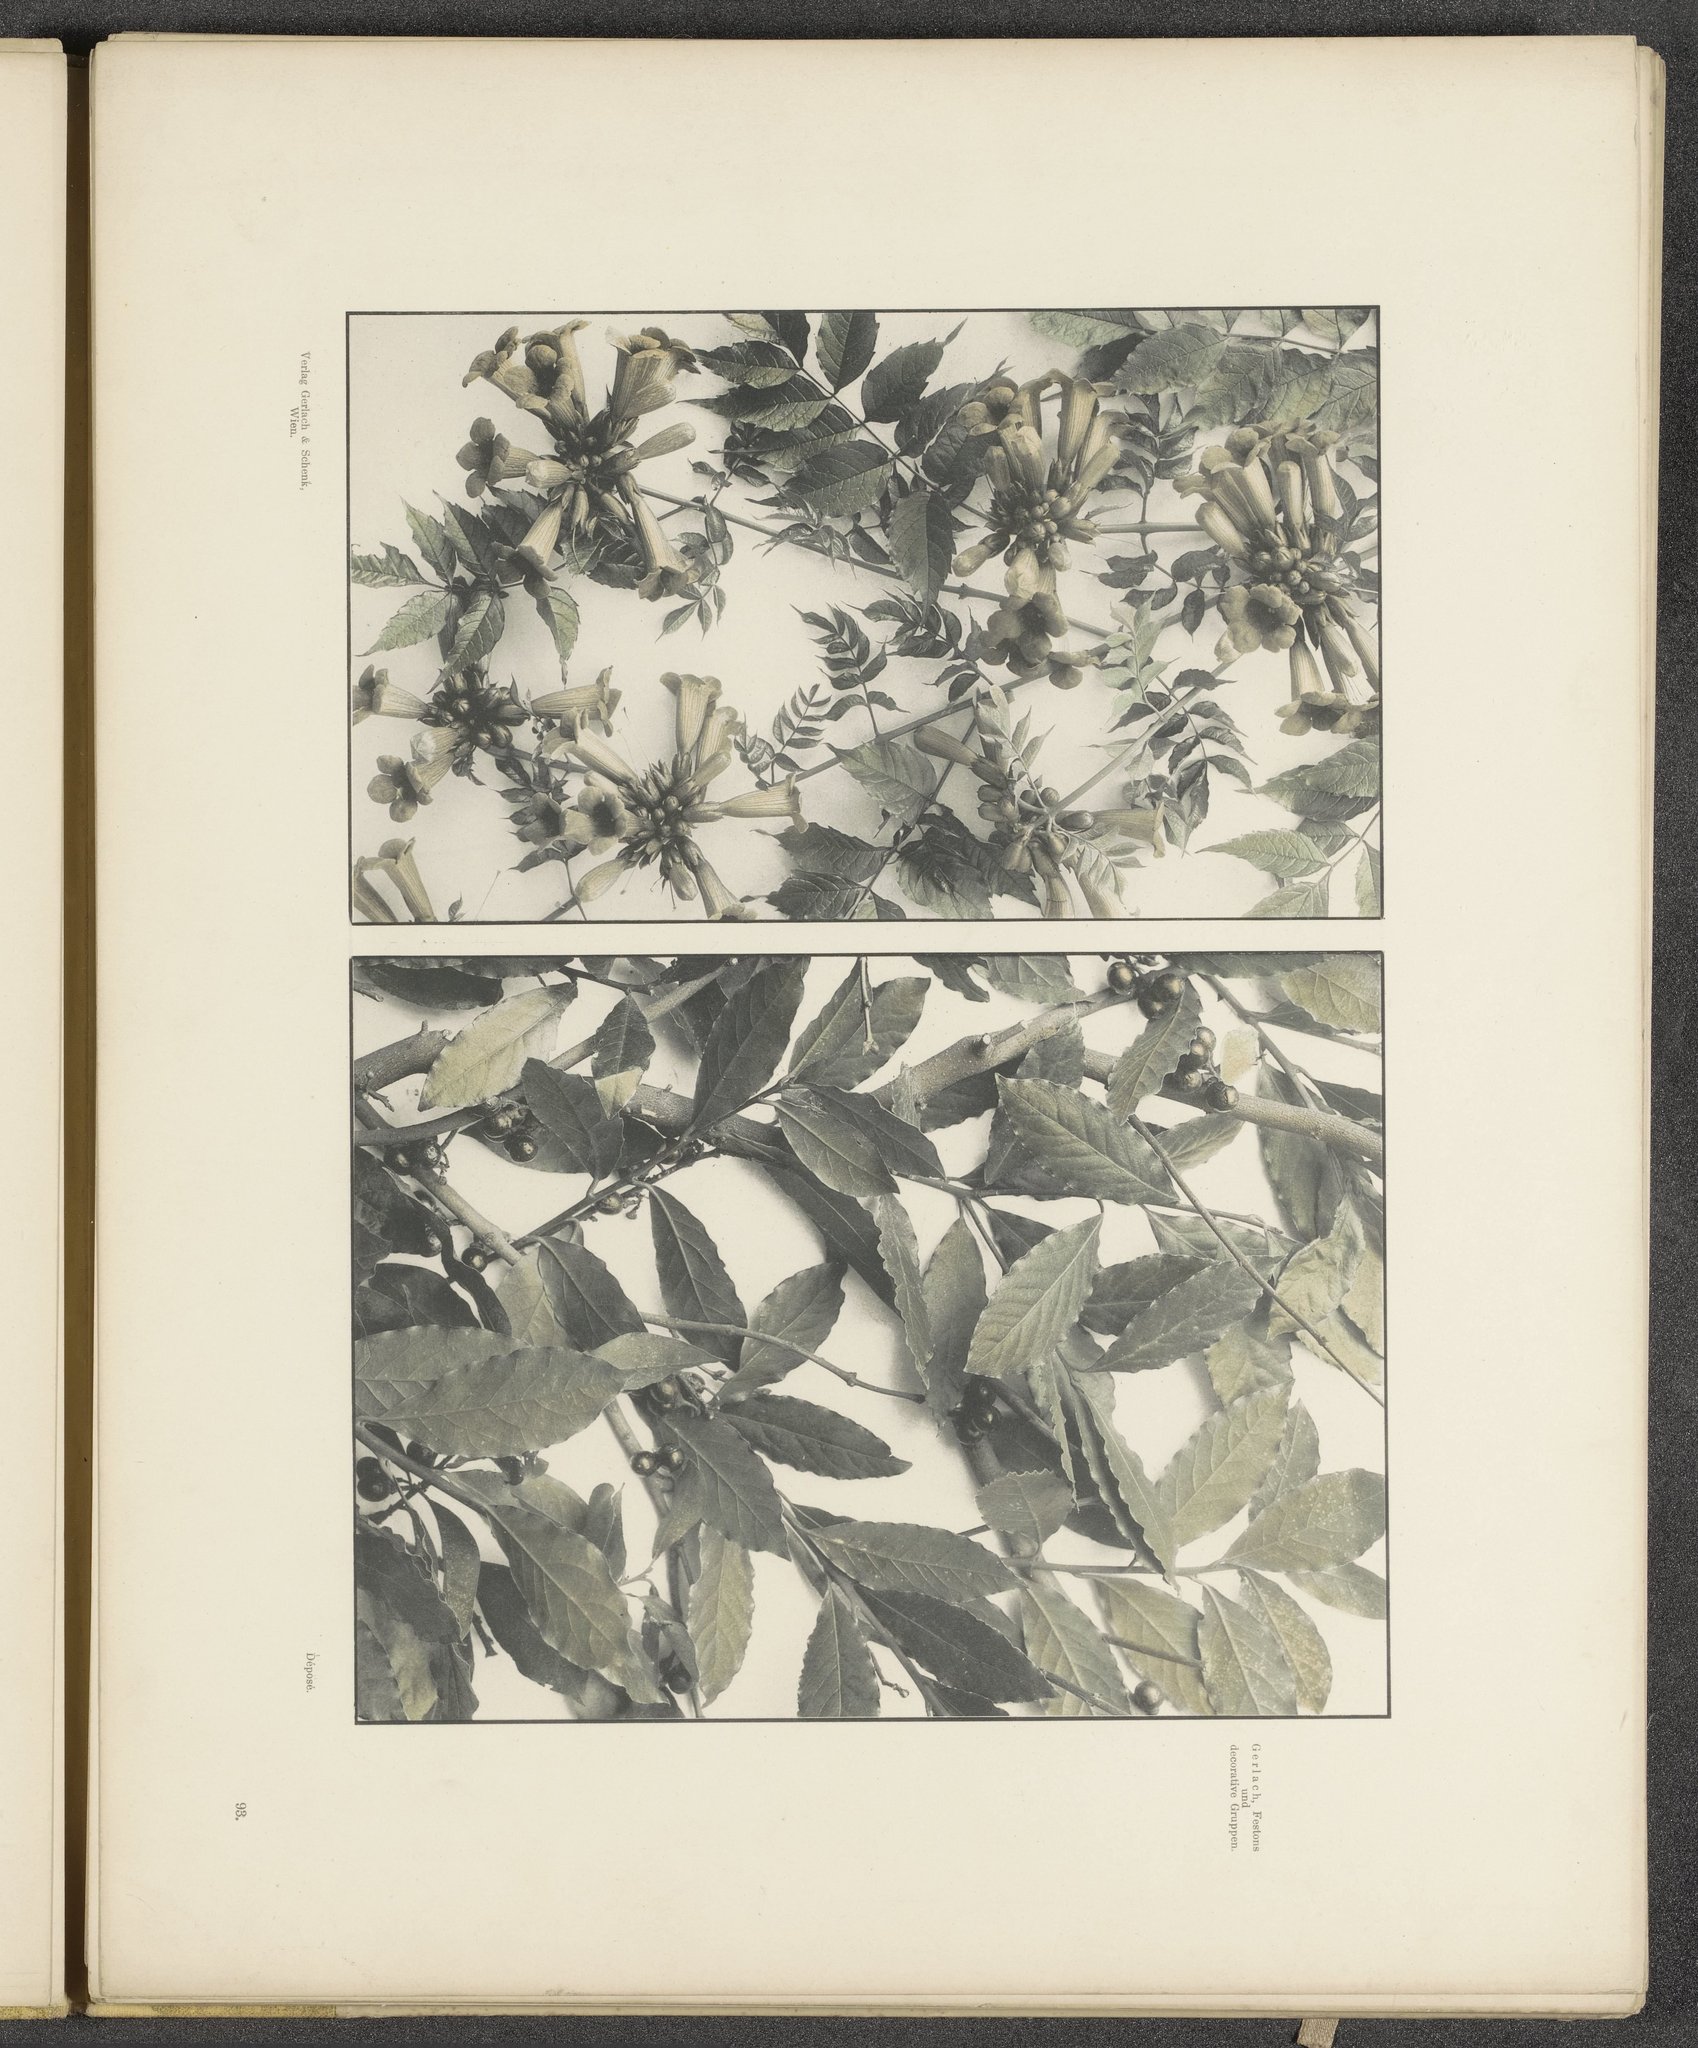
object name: page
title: Twee vlakken met trompetstruik en laurier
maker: Anonymous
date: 1887-1897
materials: paper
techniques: photograph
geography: vienna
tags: trees: laurel, foliage, tendrils, branches ~ ornament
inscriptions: number: ‘93.’